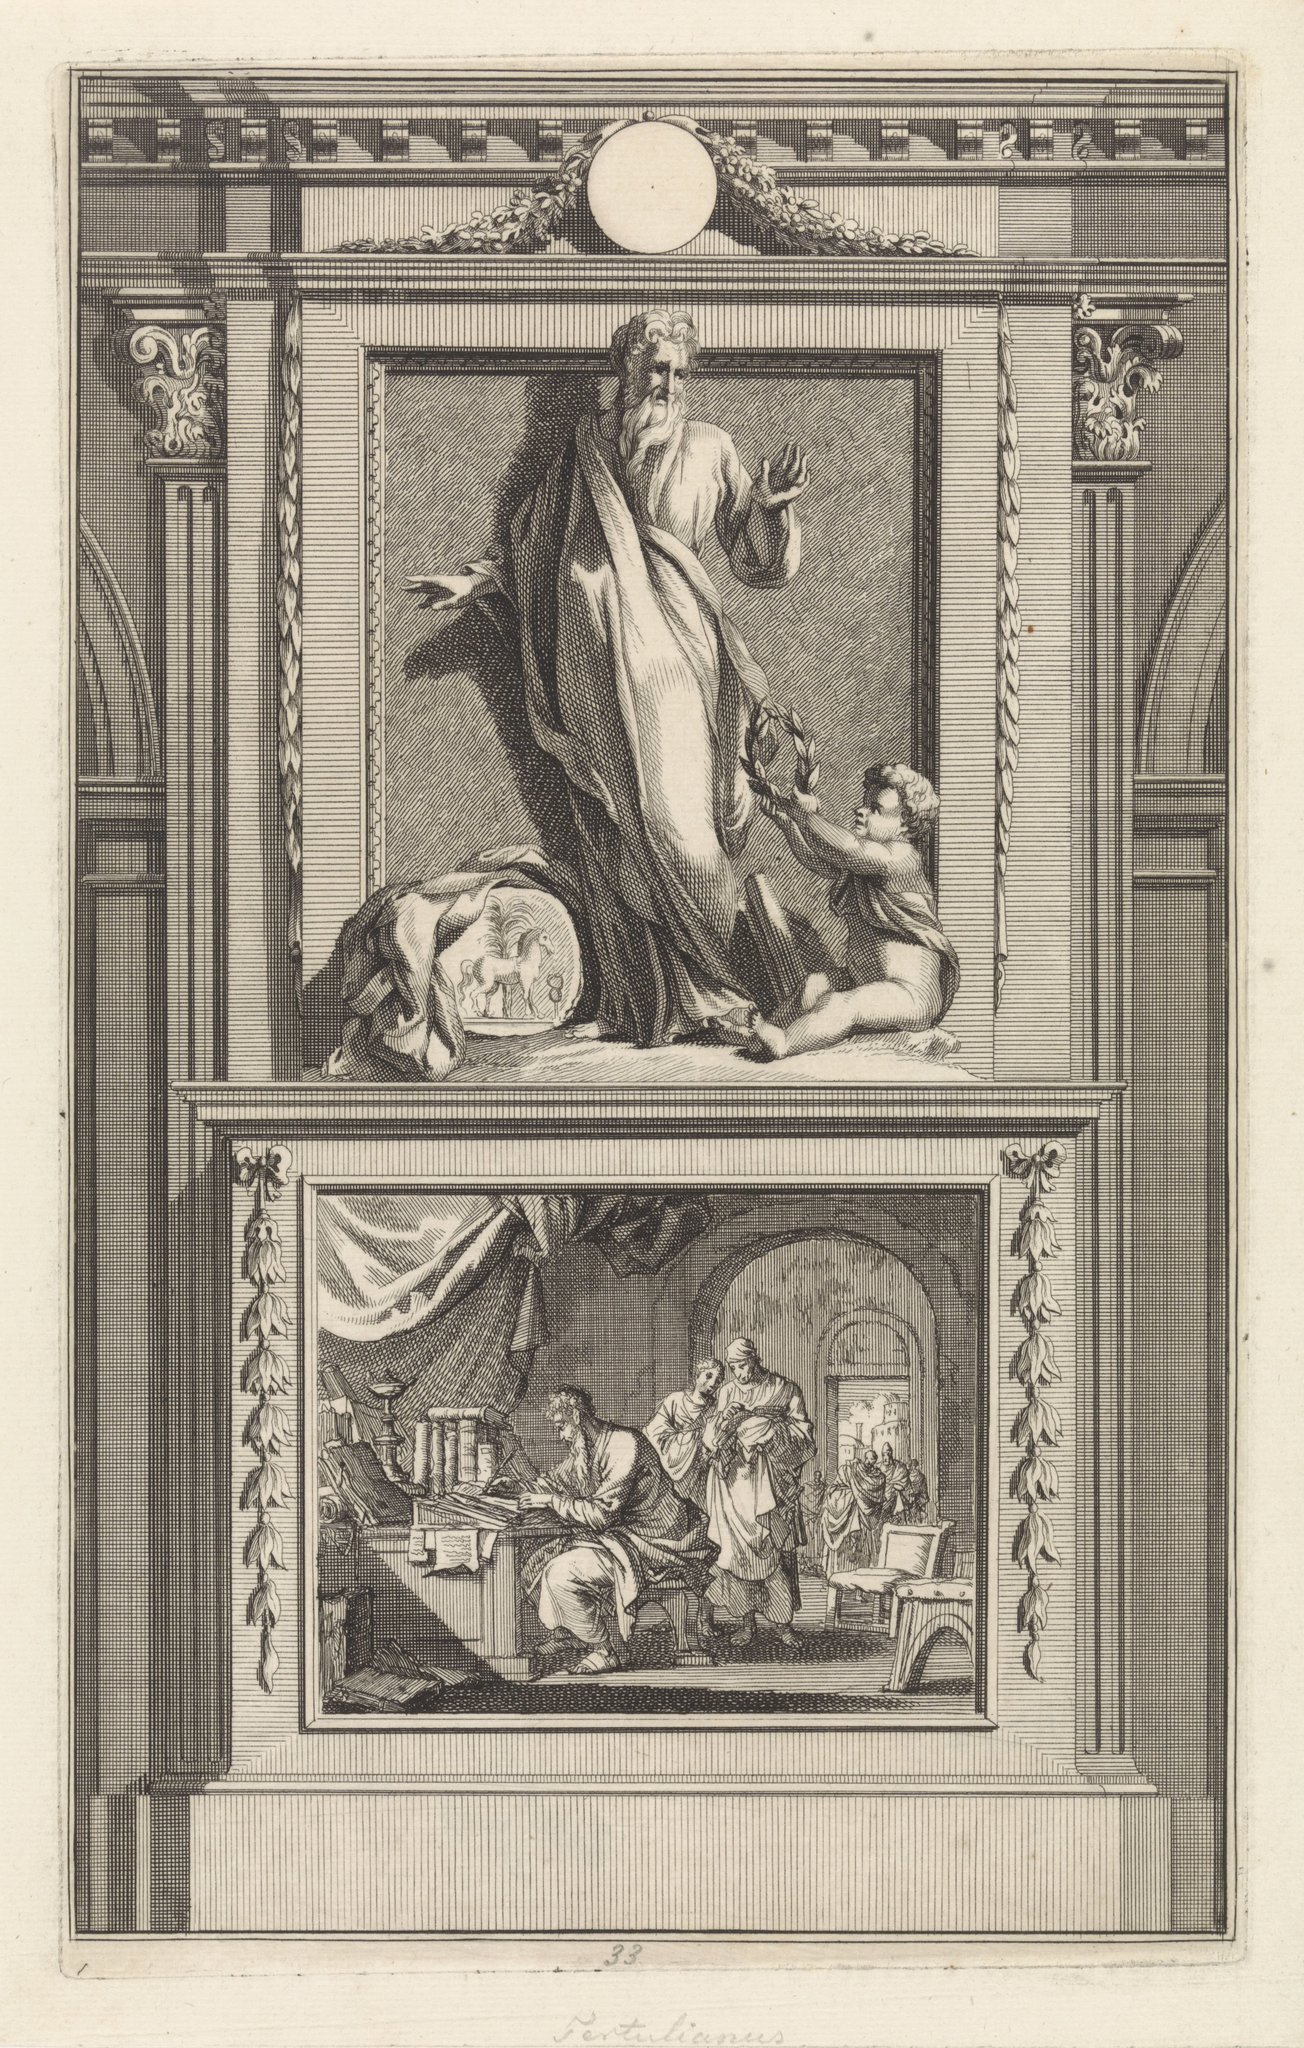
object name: print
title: Kerkvader Tertullianus van Carthago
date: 1698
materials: paper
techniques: engraving, etching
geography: amsterdam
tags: male saints (tertullian of carthage), writer, poet, author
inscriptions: number: ‘33’, collector's mark: Lugt 2228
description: De kerkvader Tertullianus van Carthago kijkt naar een engel die hem een lauwerkrans aanbiedt. Tertullianus staat op een sokkel. Op de voorzijde een scène waarin hij een van zijn geschriften schrijft.